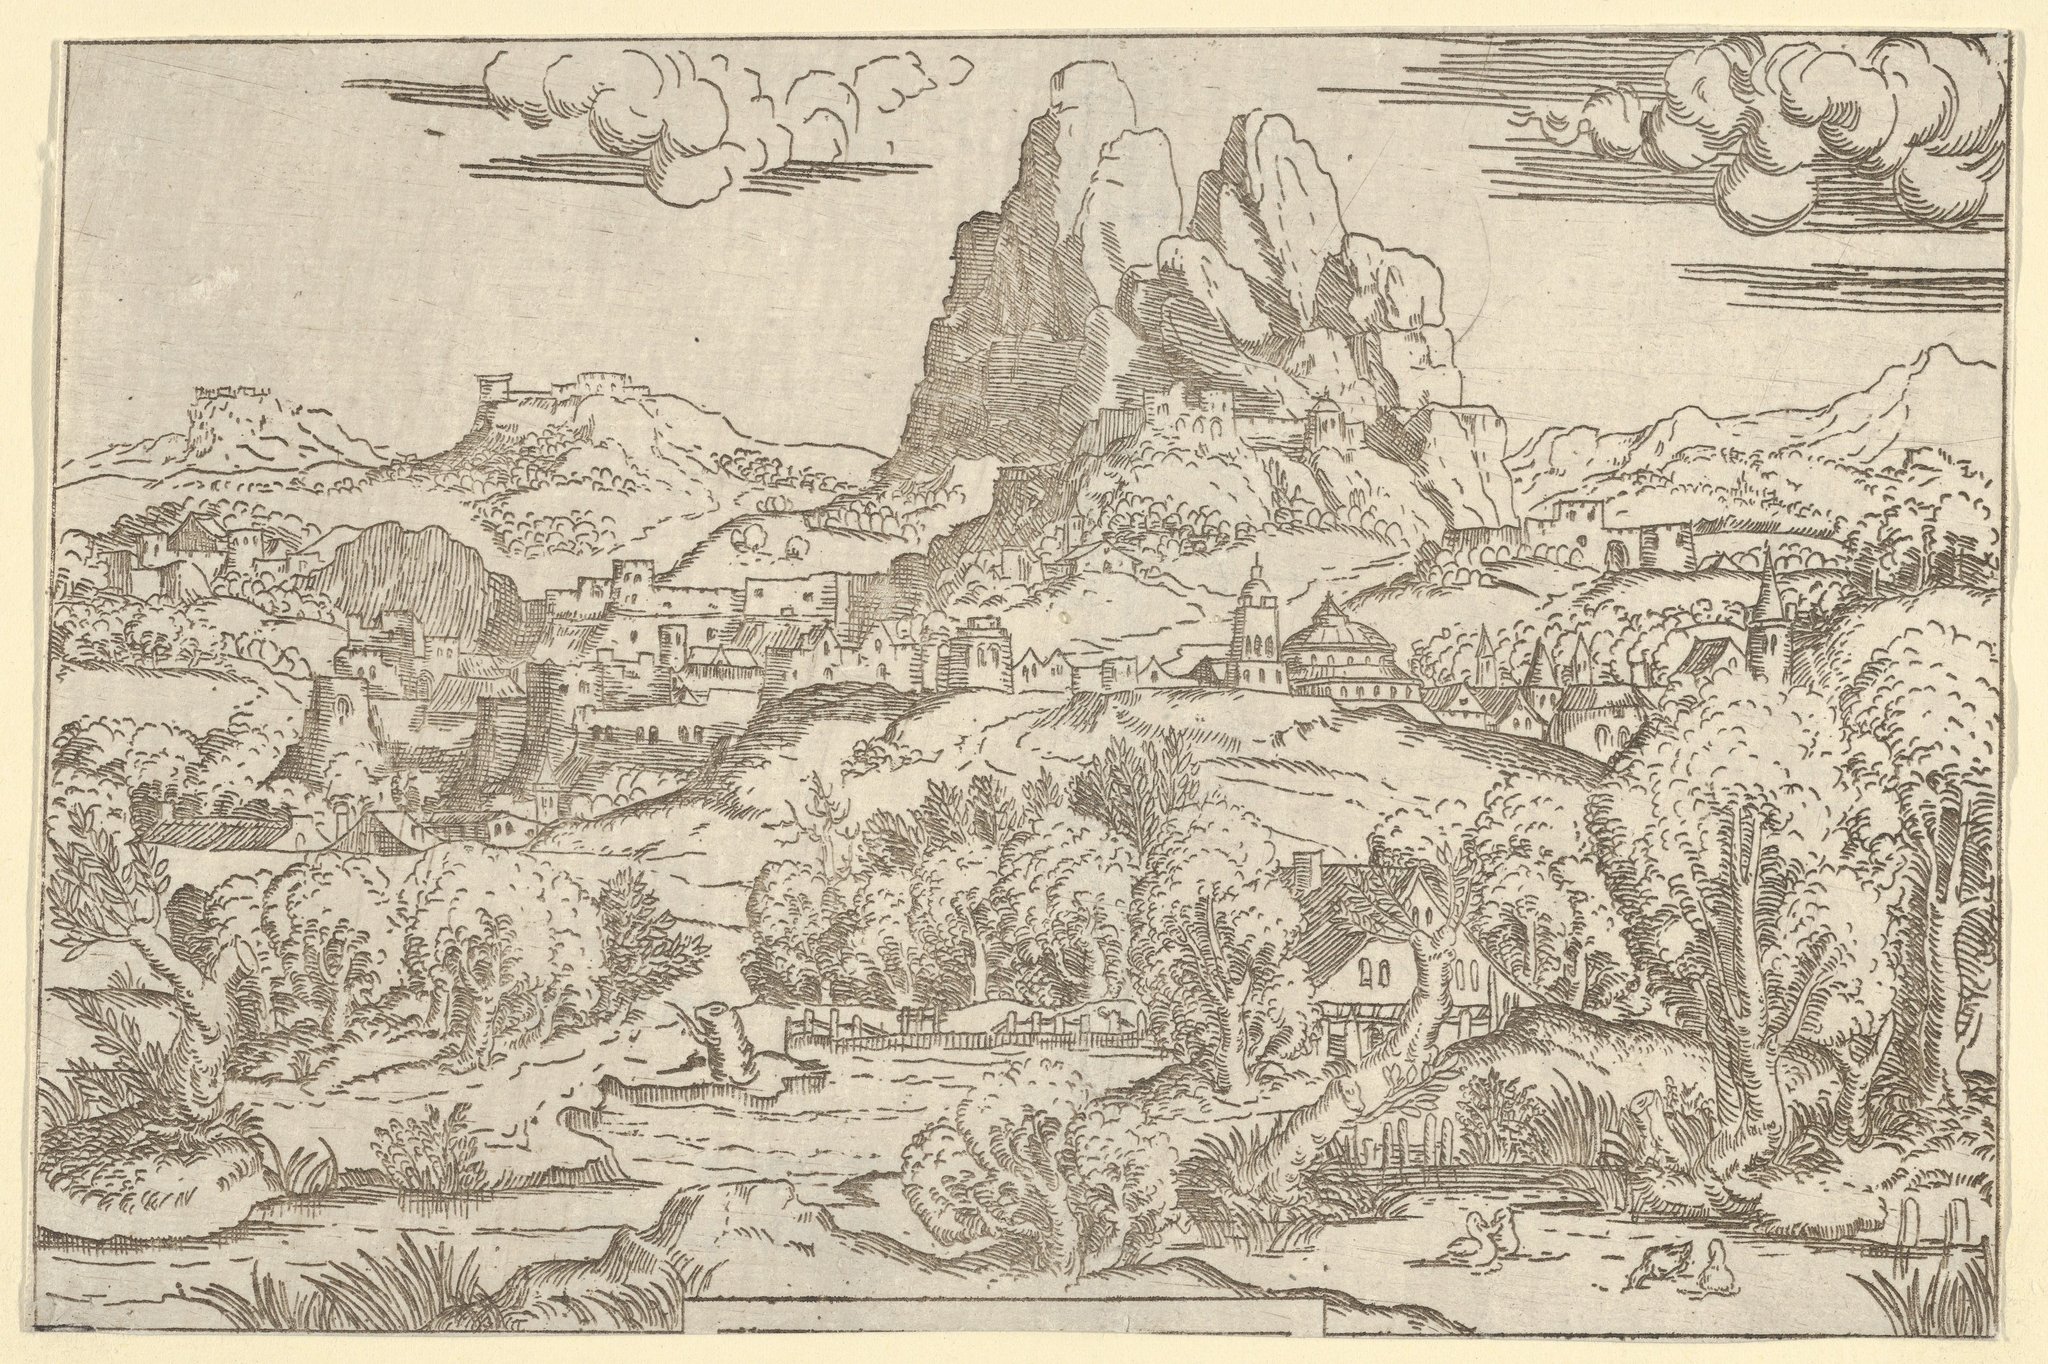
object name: print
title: Landscape from "Venus Pushing Cupid" frame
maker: antonio fantuzzi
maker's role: artist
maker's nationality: italian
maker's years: 1537-1545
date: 1540-1545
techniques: etching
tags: houses,hills,landscapes